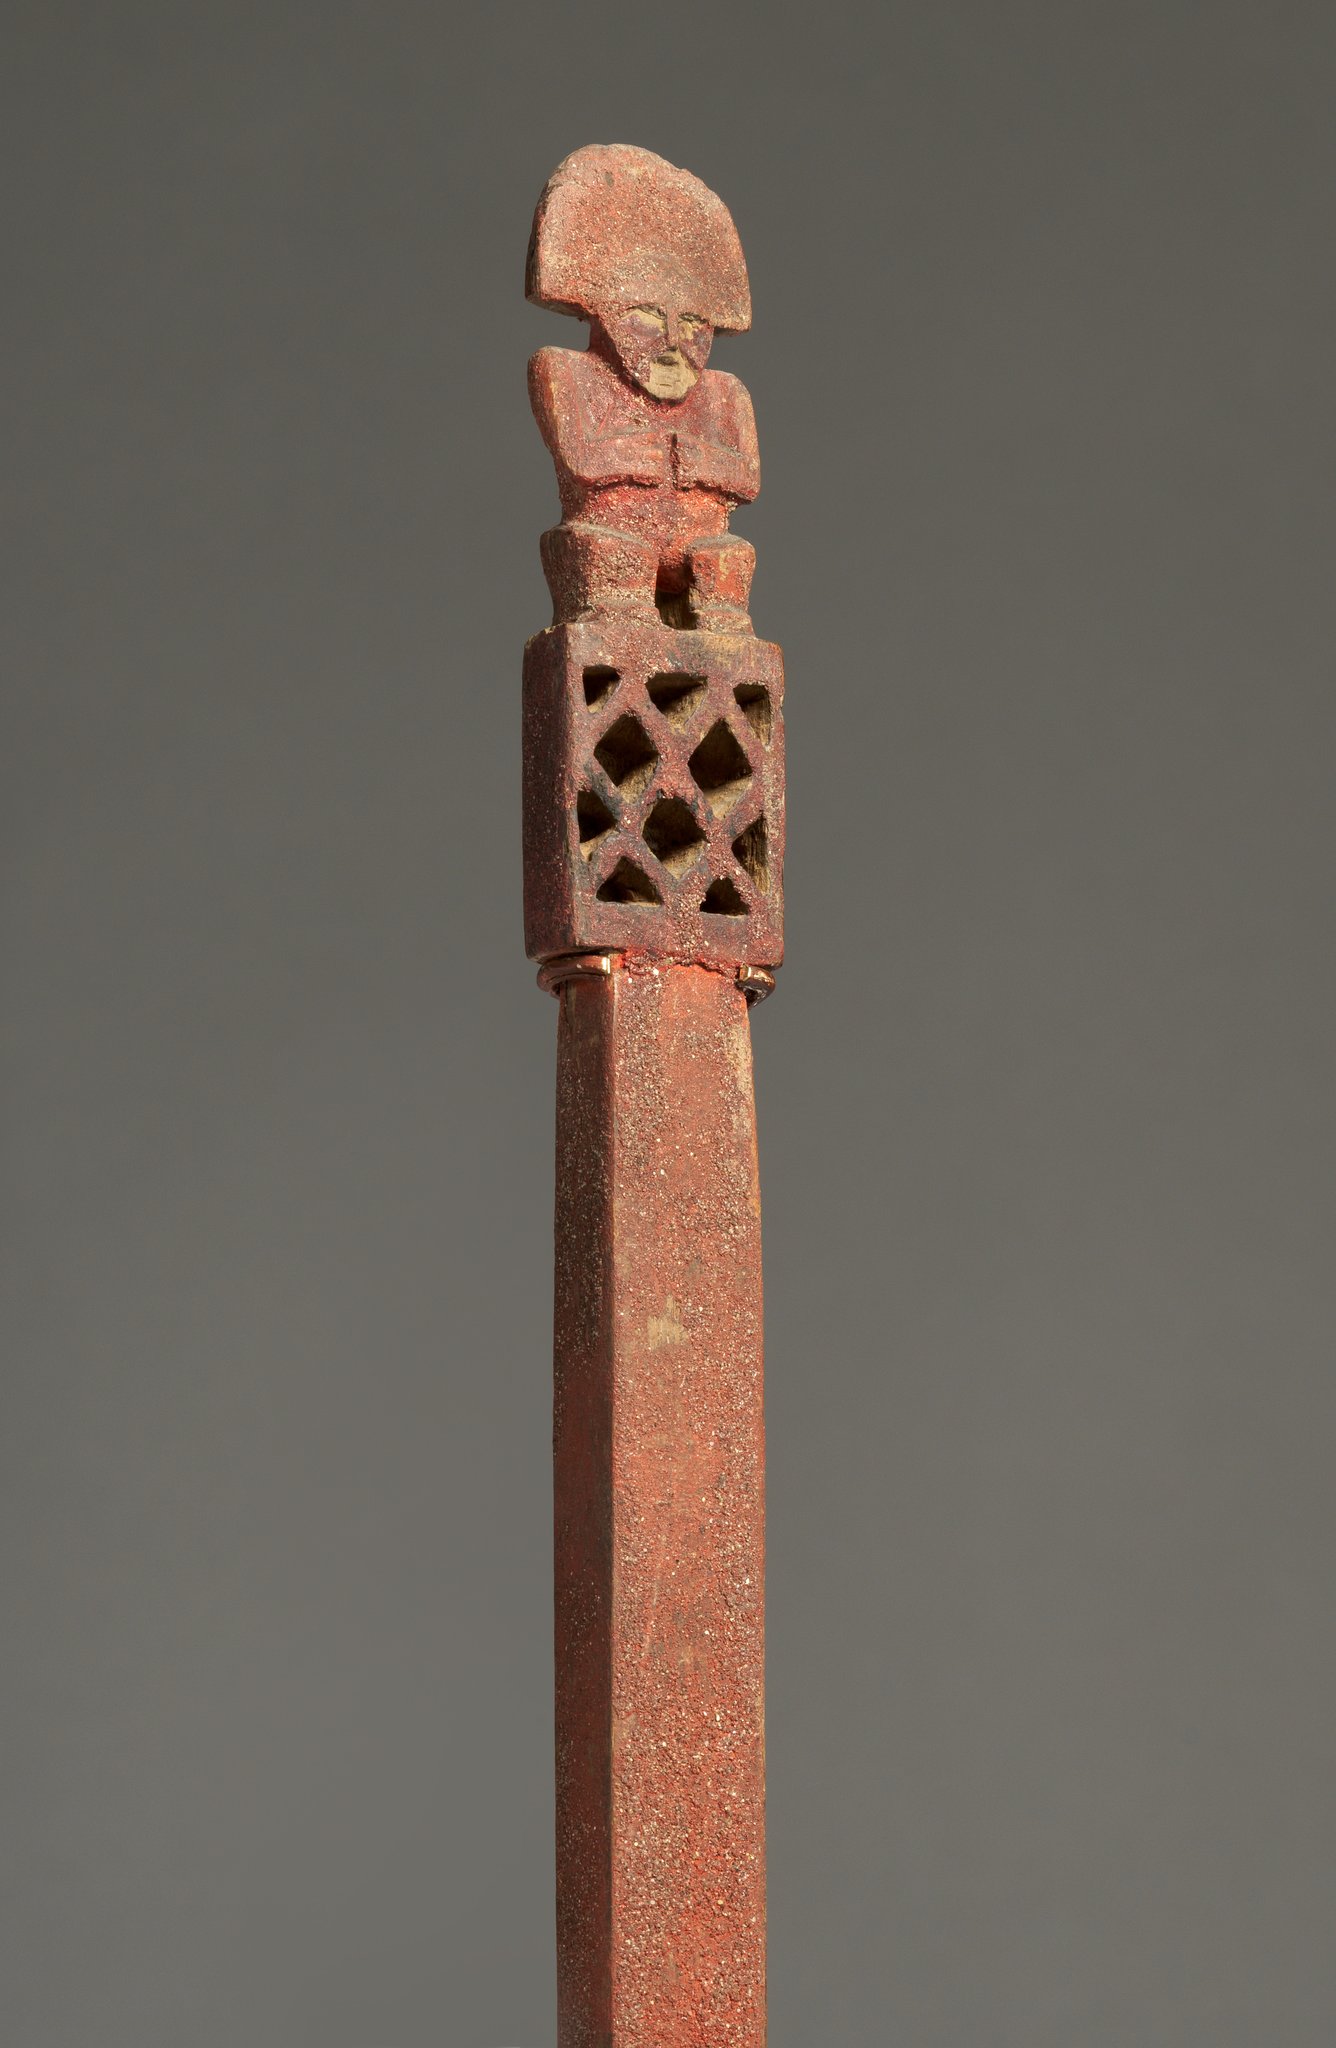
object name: tomb staff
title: Funerary staff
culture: inca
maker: inca artist(s)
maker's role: artist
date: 1400-1535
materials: paint, wood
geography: peru